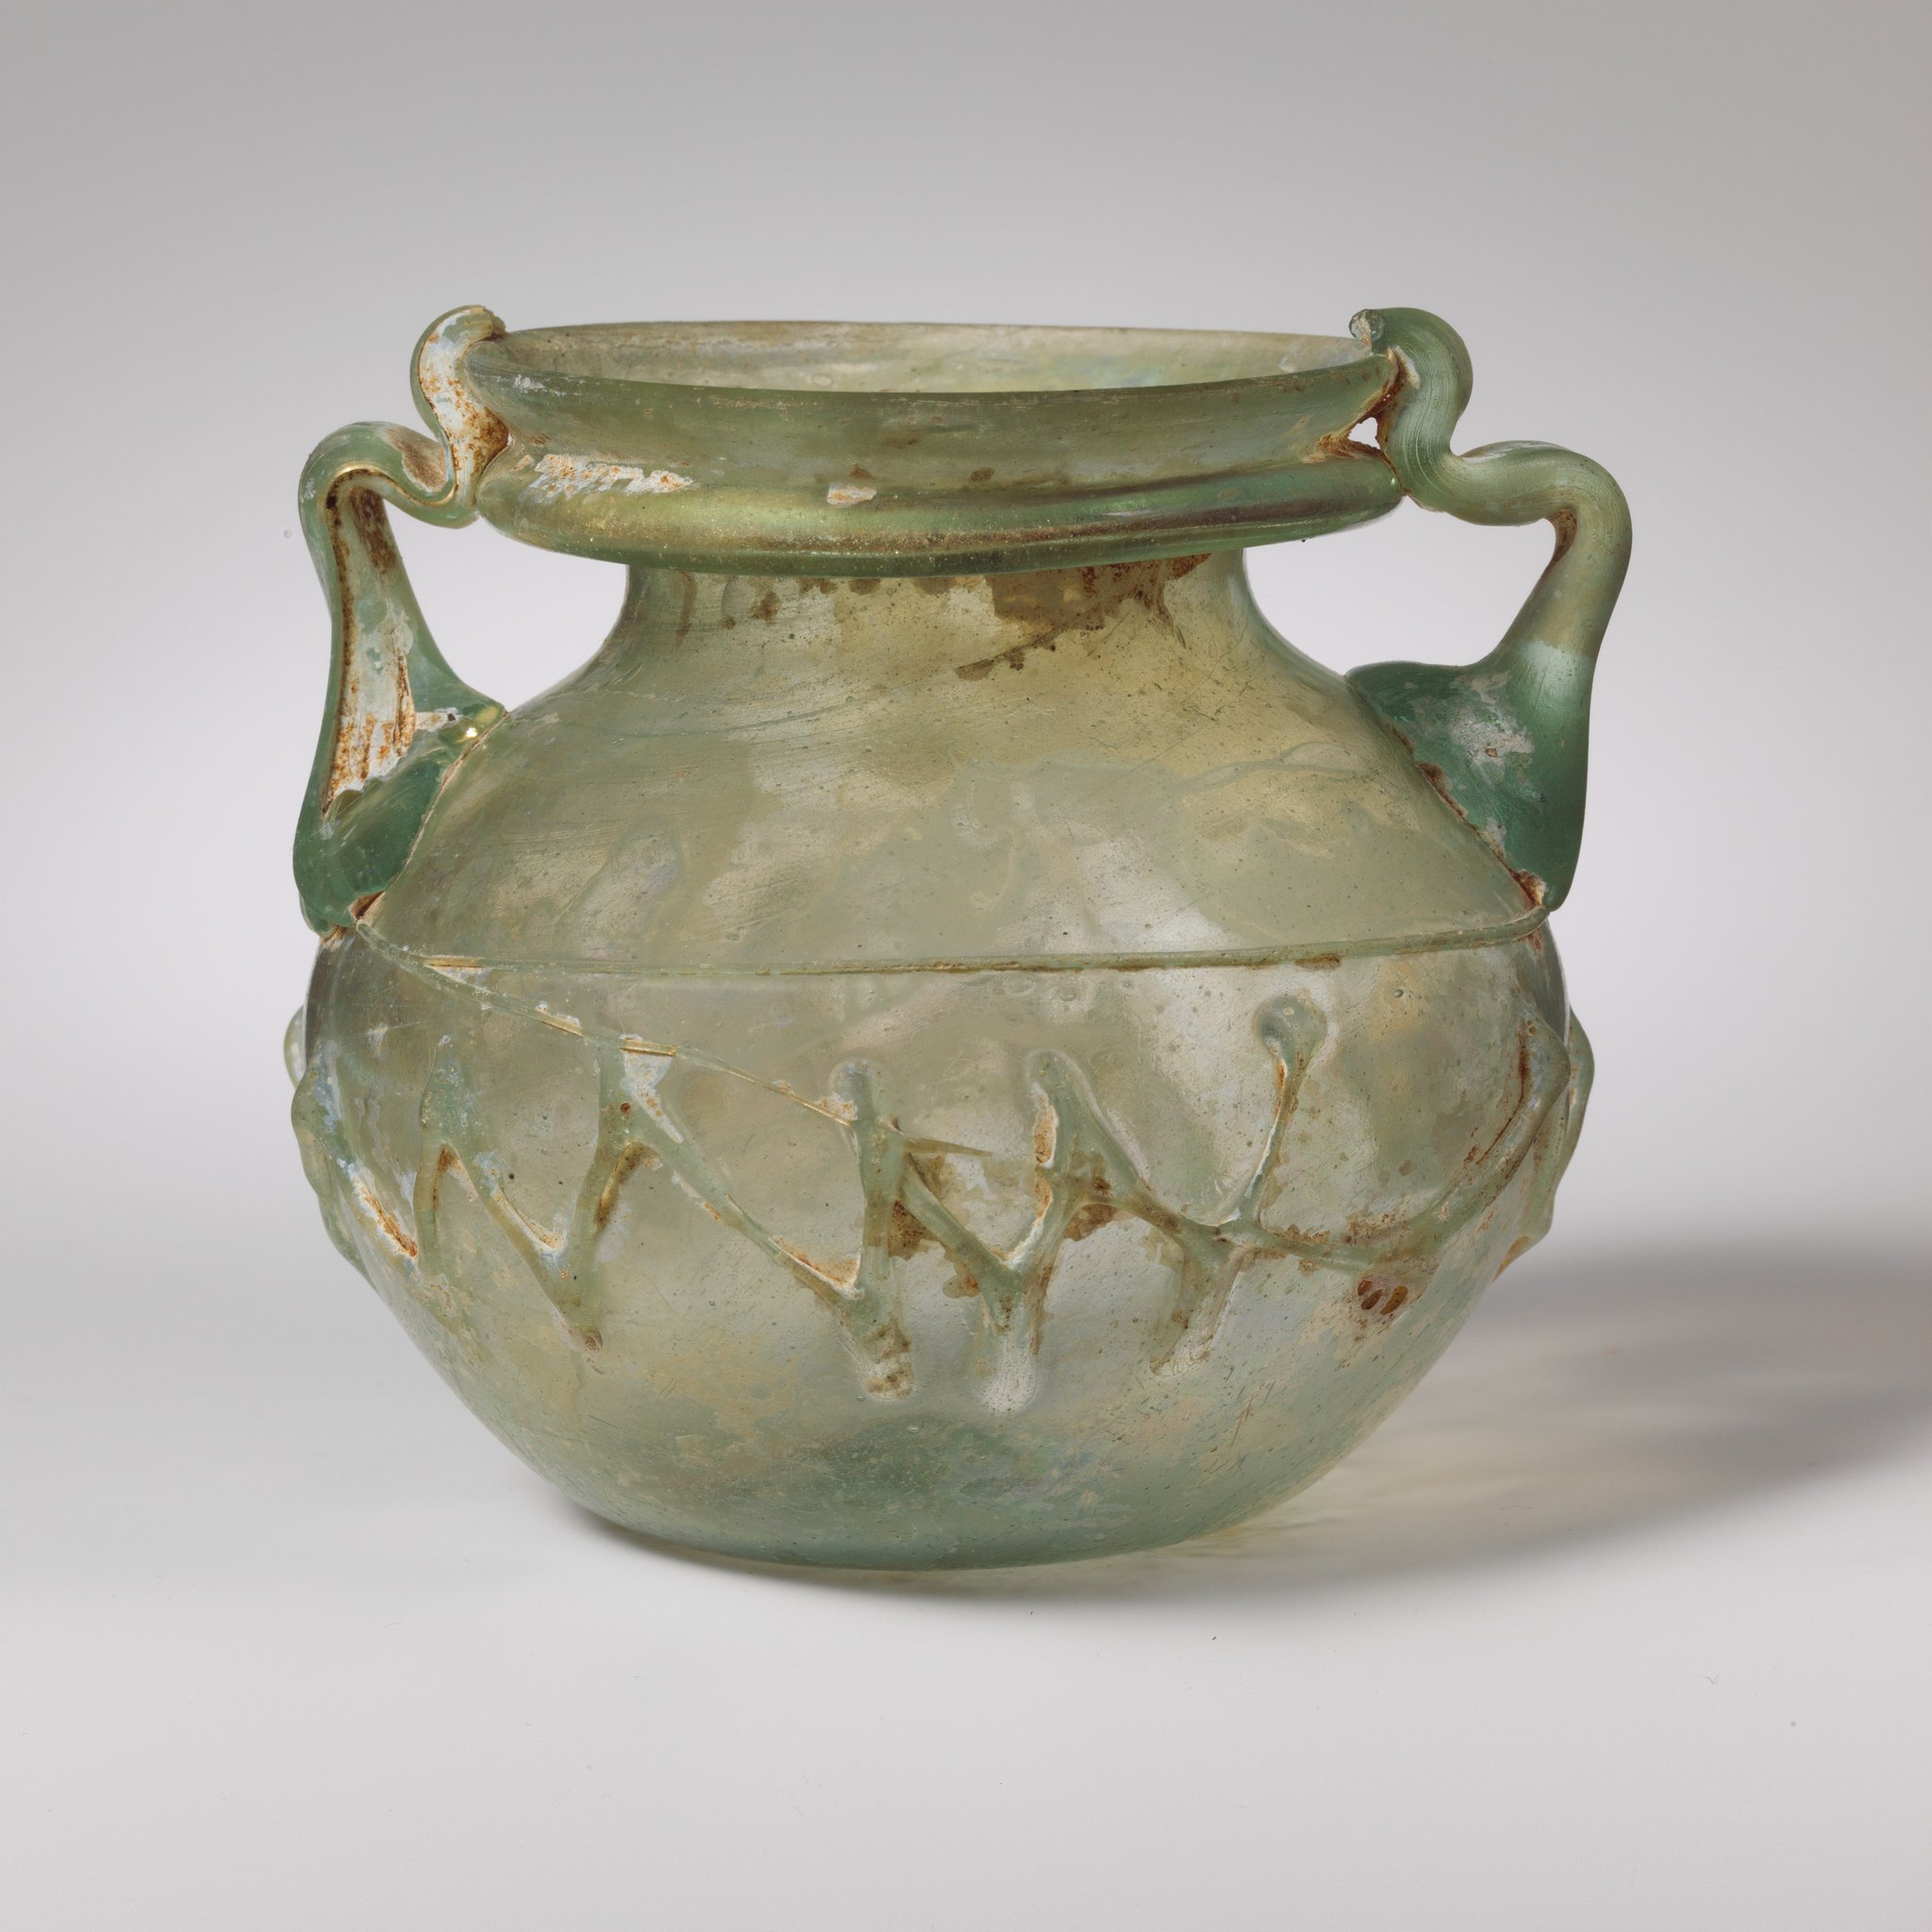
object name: jar with handle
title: Glass two-handled jar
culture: roman, palestinian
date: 201-400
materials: glass